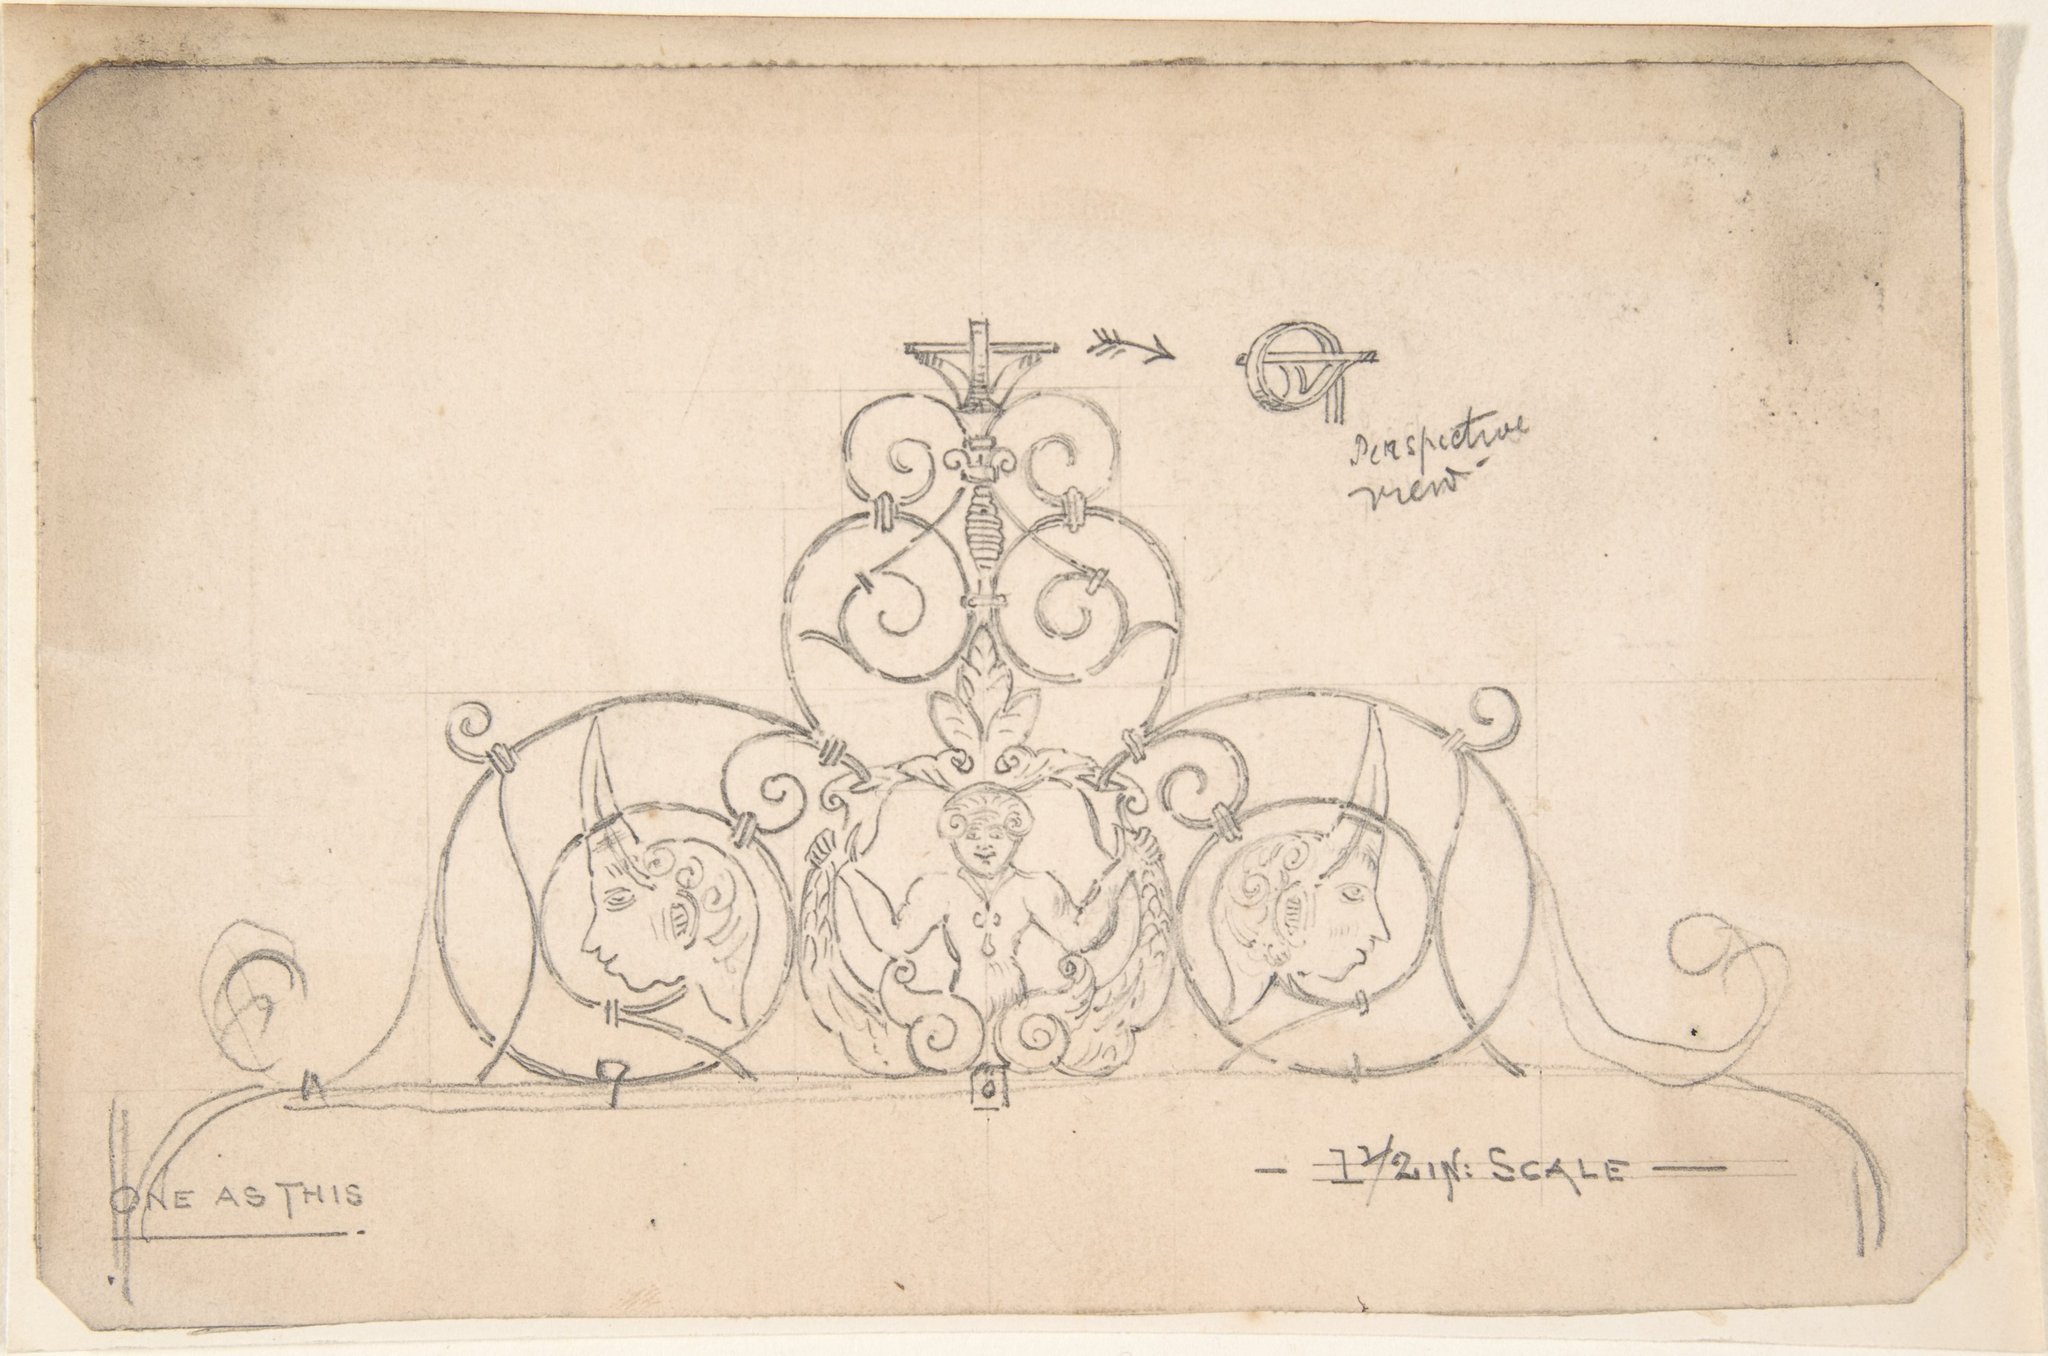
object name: drawing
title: Wrought Metal Foliate Ornament with Grotesque Masks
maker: anonymous, british, 19th century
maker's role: artist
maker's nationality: british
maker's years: 1800-1900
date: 1870-1890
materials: graphite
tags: human figures,masks,ornament